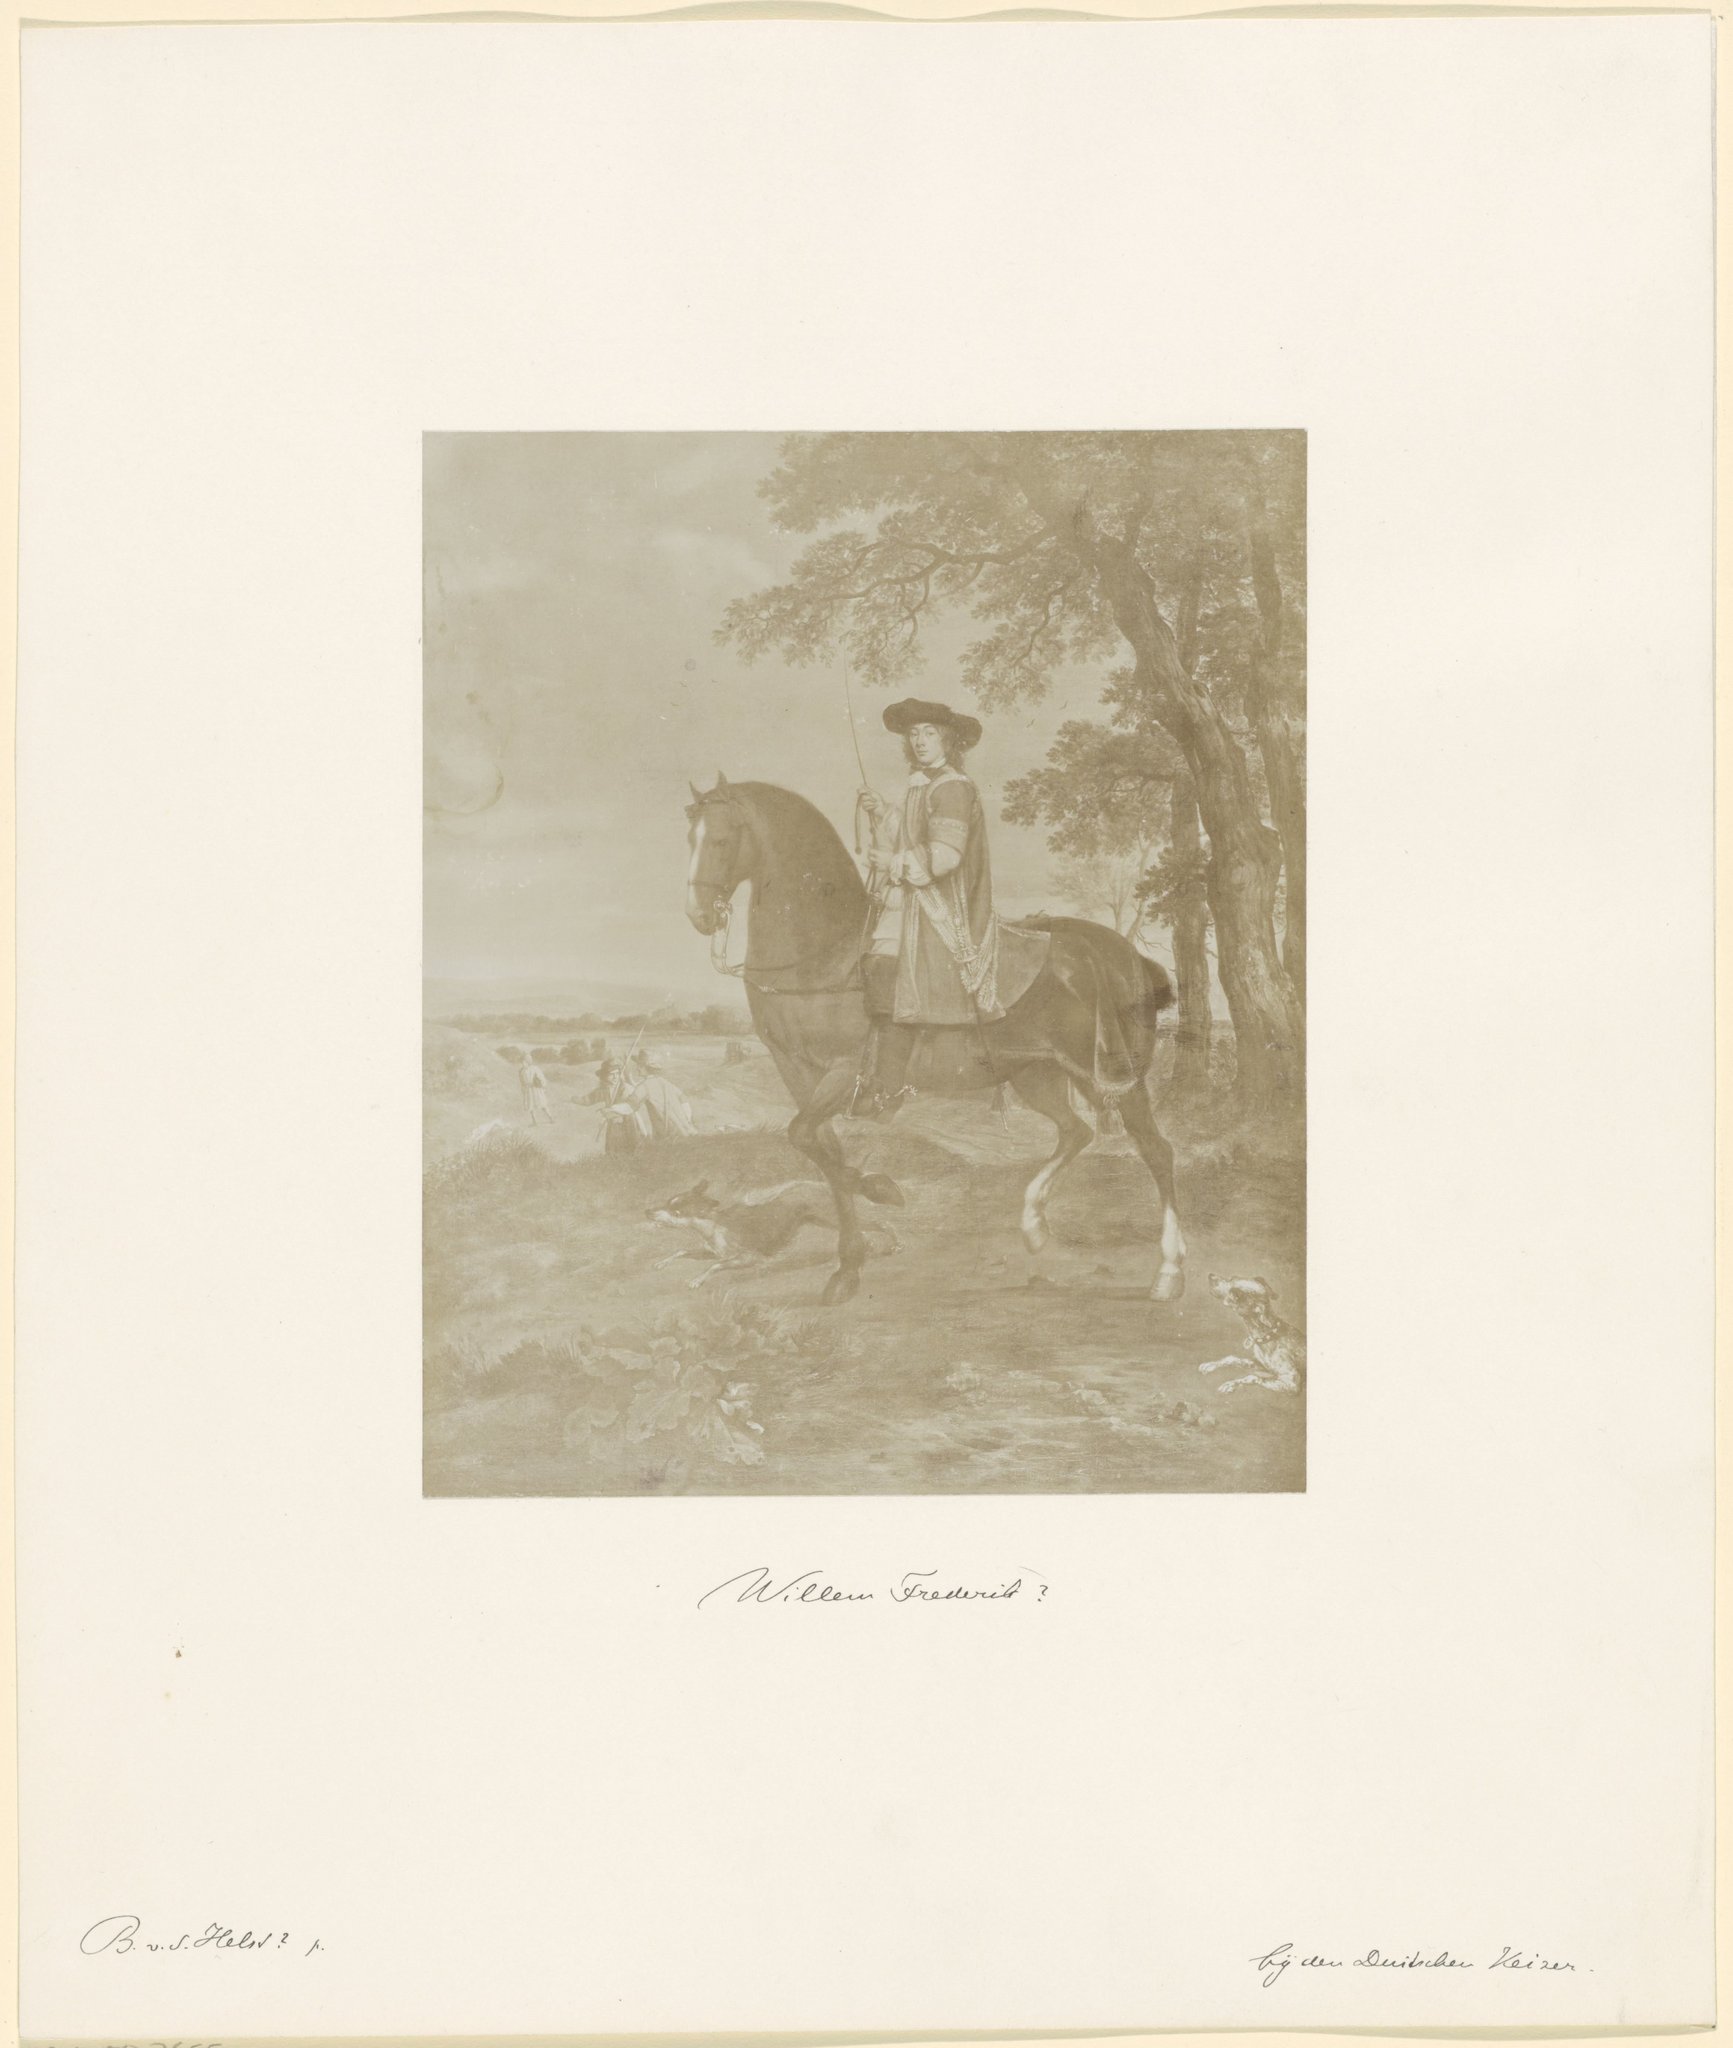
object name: photograph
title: Ruiterportret van Willem Frederik, graaf van Nassau-Dietz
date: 1850-1930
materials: photographic support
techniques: collodion silver print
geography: netherlands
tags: arnhem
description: De hier vermelde titel verwijst naar de hoogst verkregen titel van de geportretteerde, niet per se naar de titel die de geportretteerde op deze voorstelling draagt.